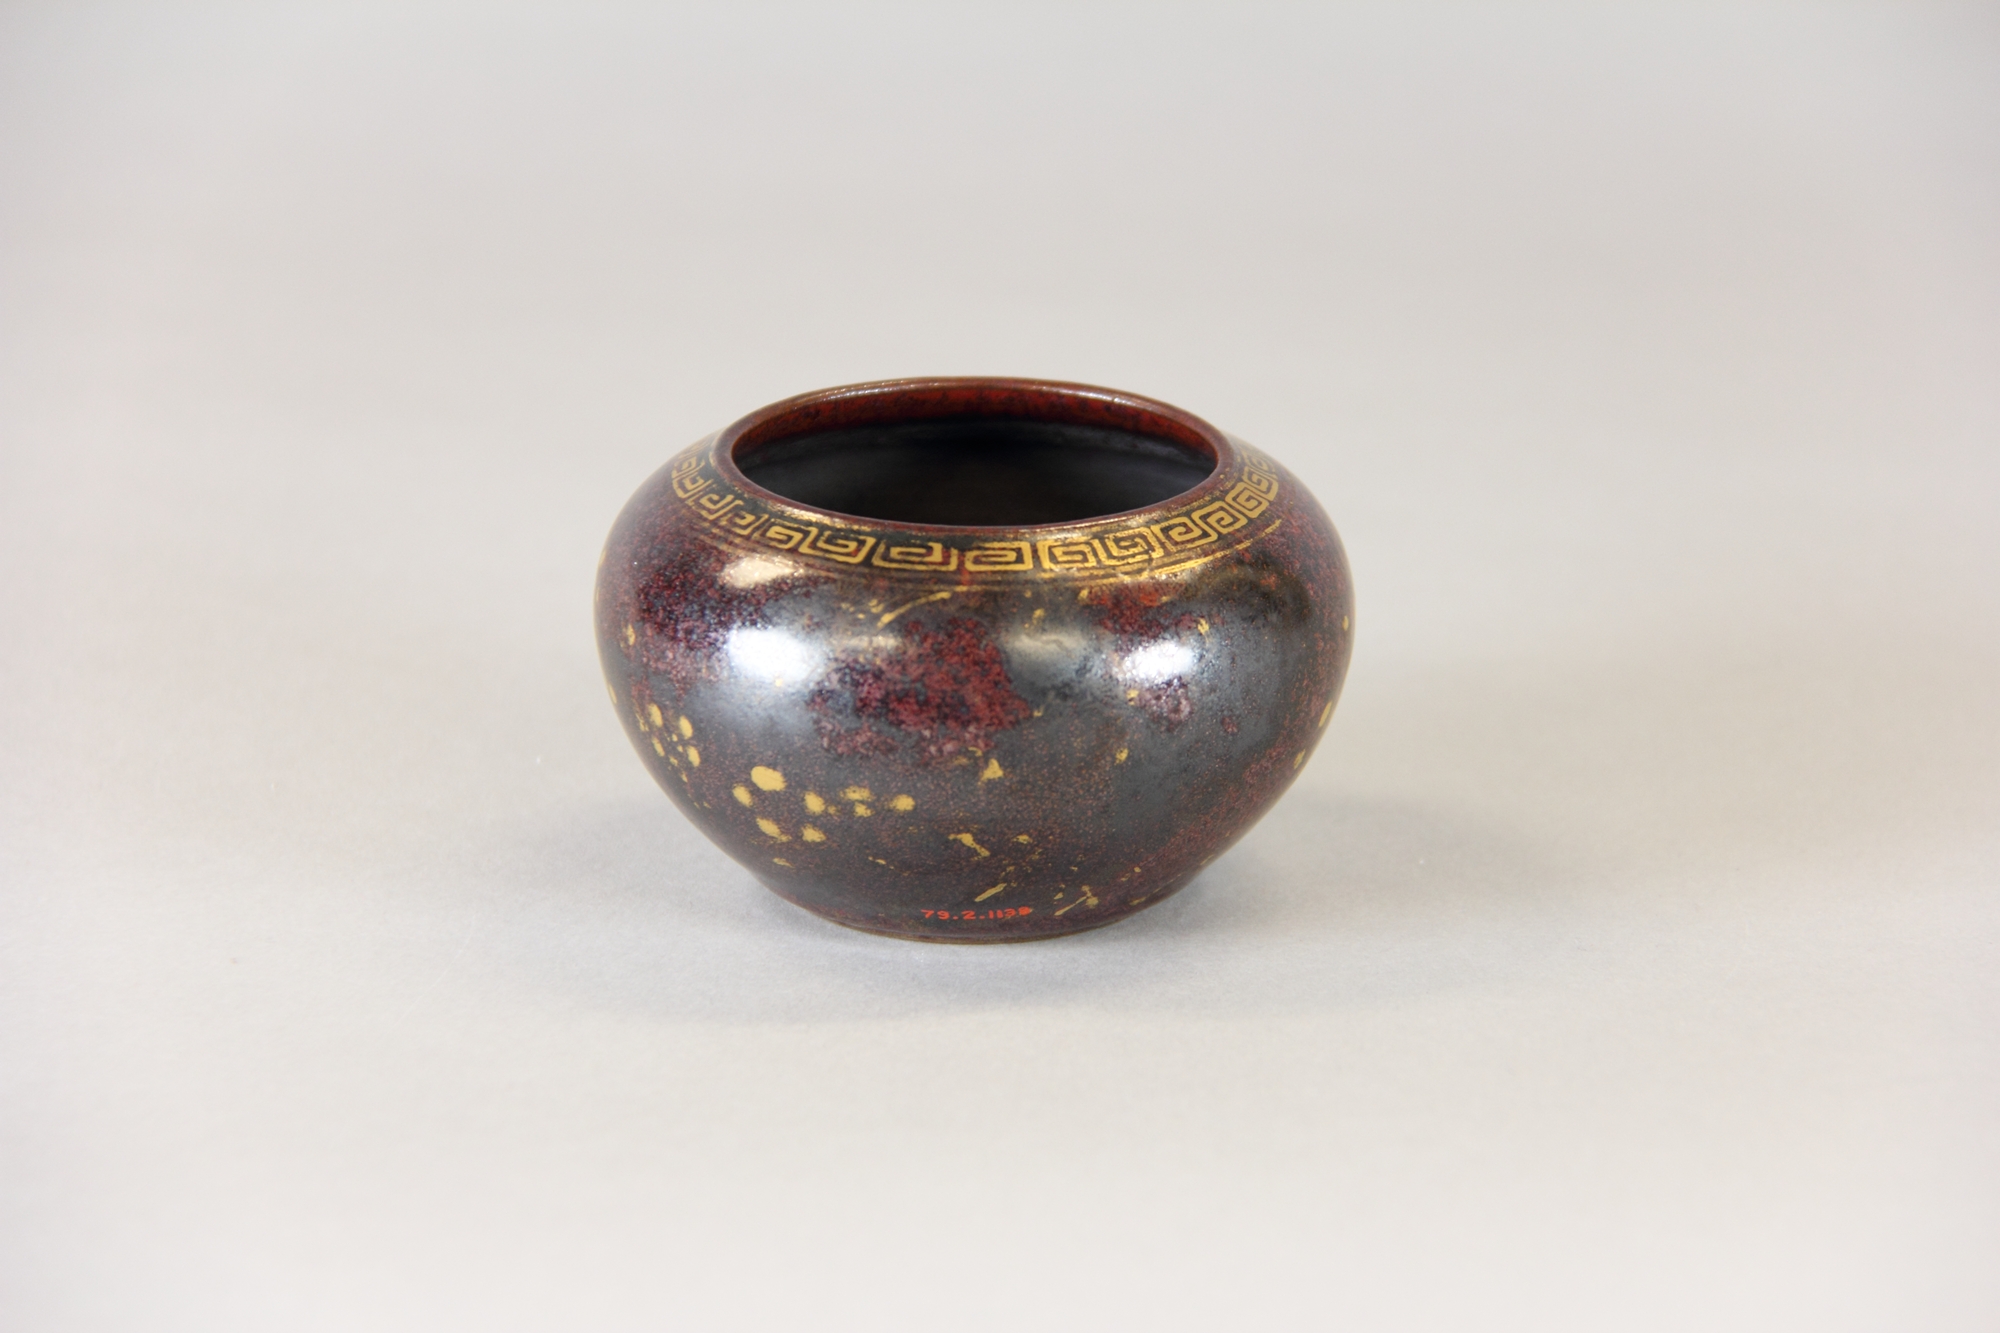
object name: jar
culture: chinese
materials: gilt, glaze, iron, porcelain